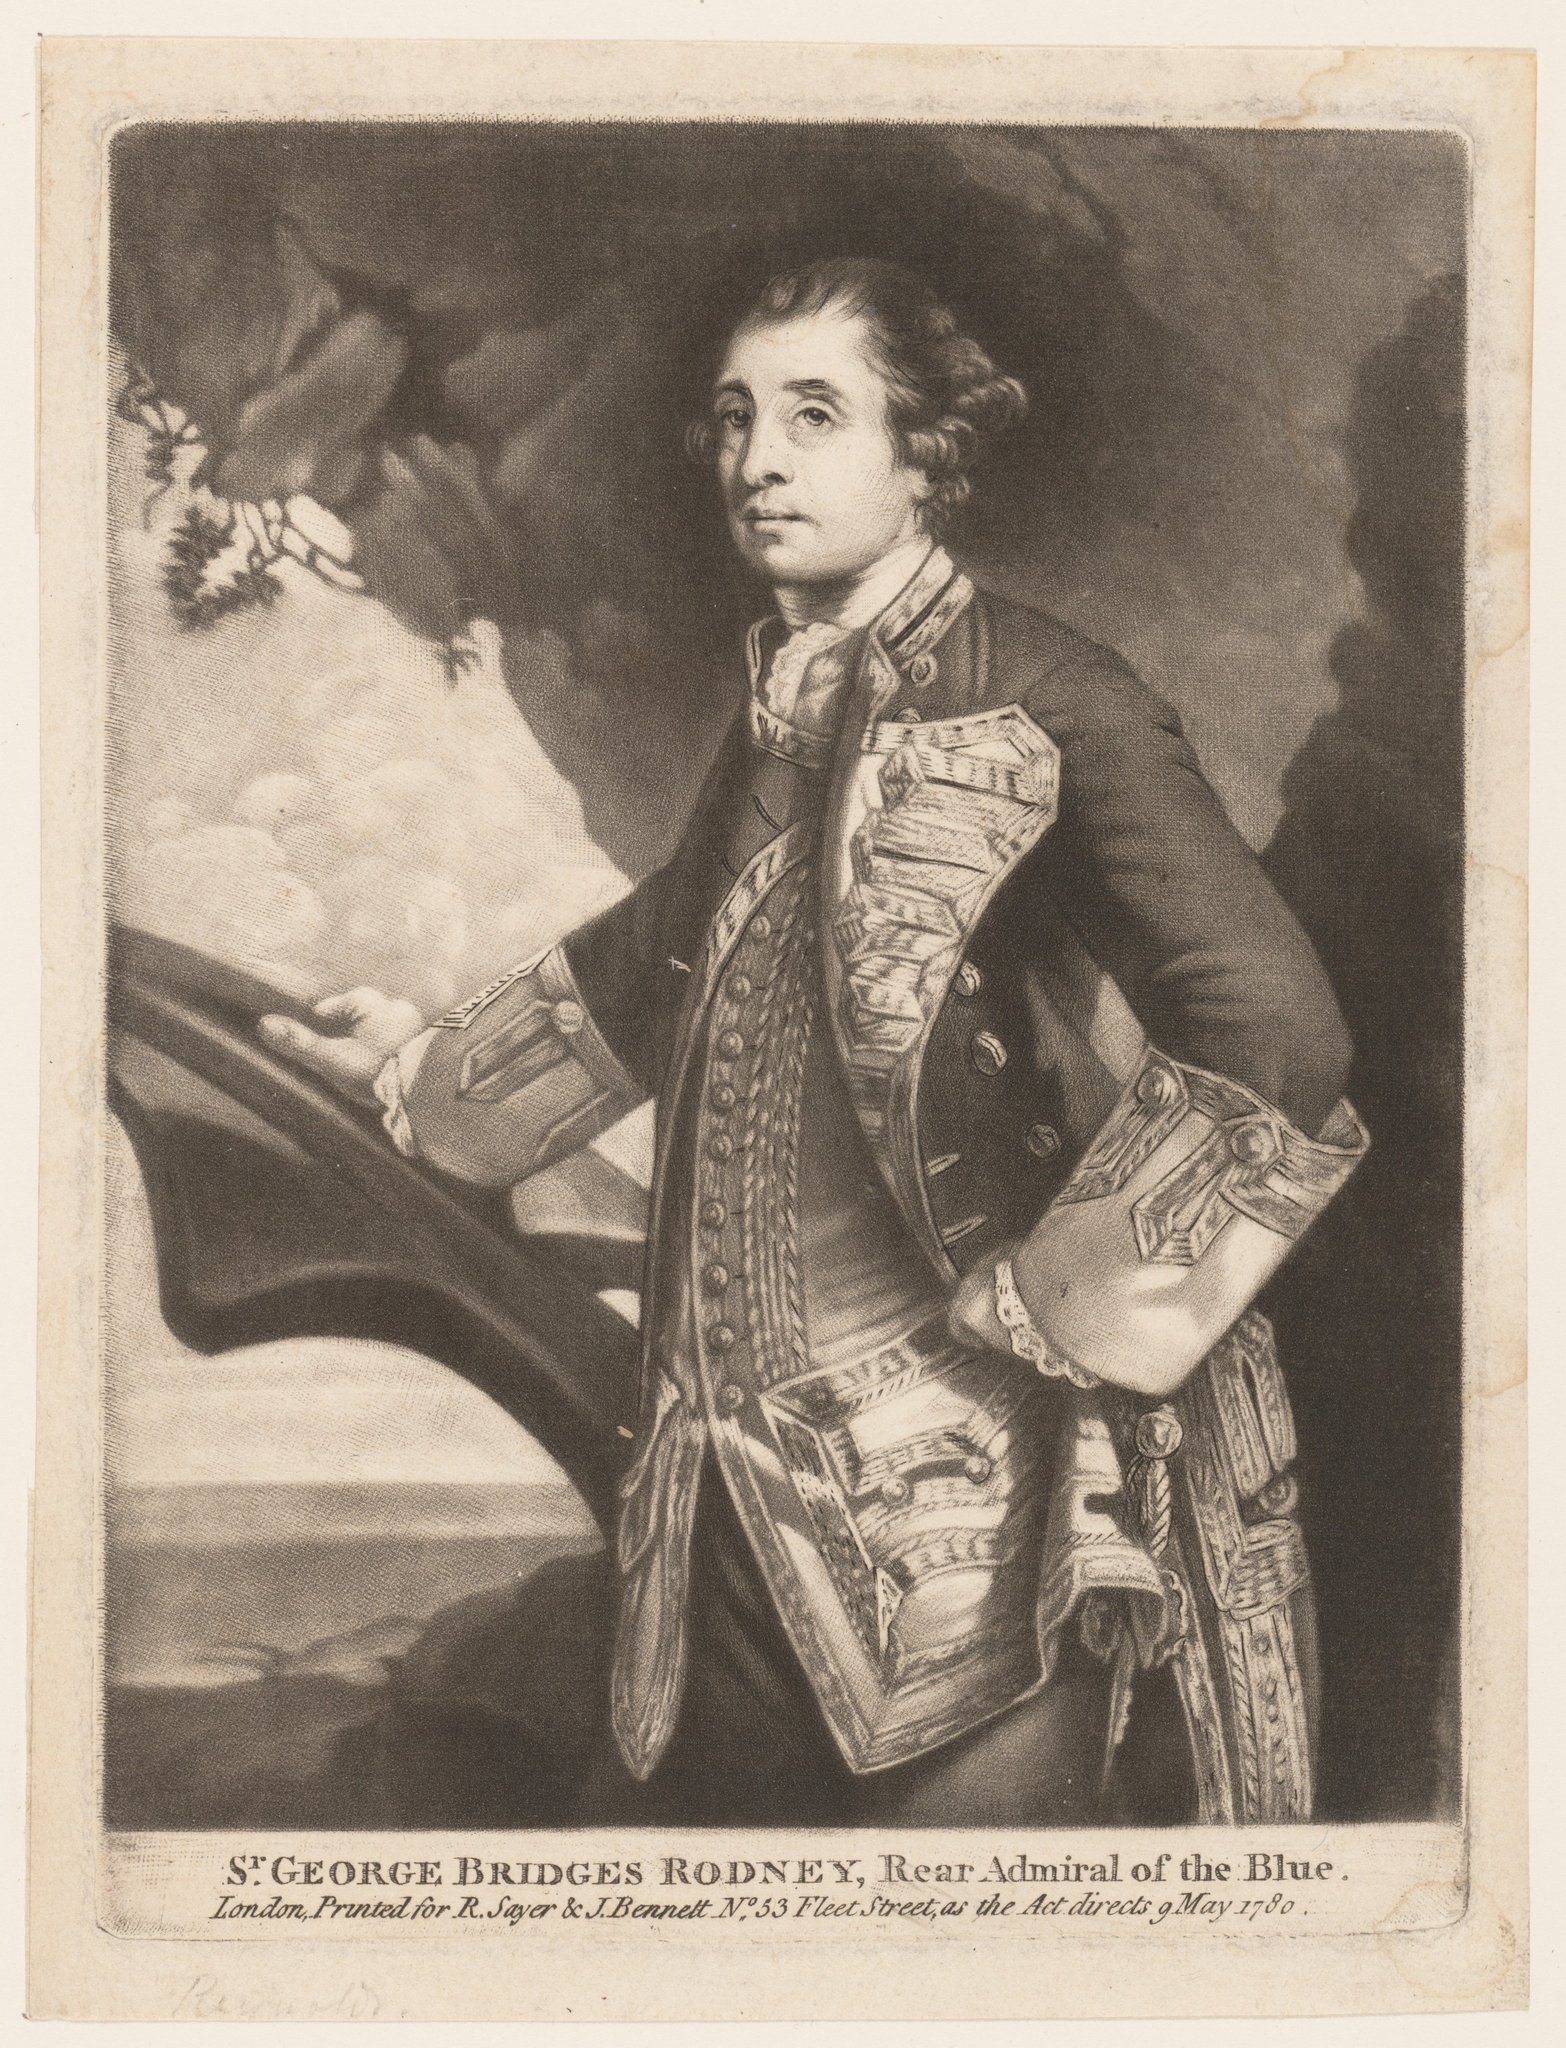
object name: print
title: Sr. George Bridges Rodney, Rear Admiral of the Blue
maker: anonymous, british, late 18th century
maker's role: engraver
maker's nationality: british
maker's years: 1750-1800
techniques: mezzotint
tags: men,portraits